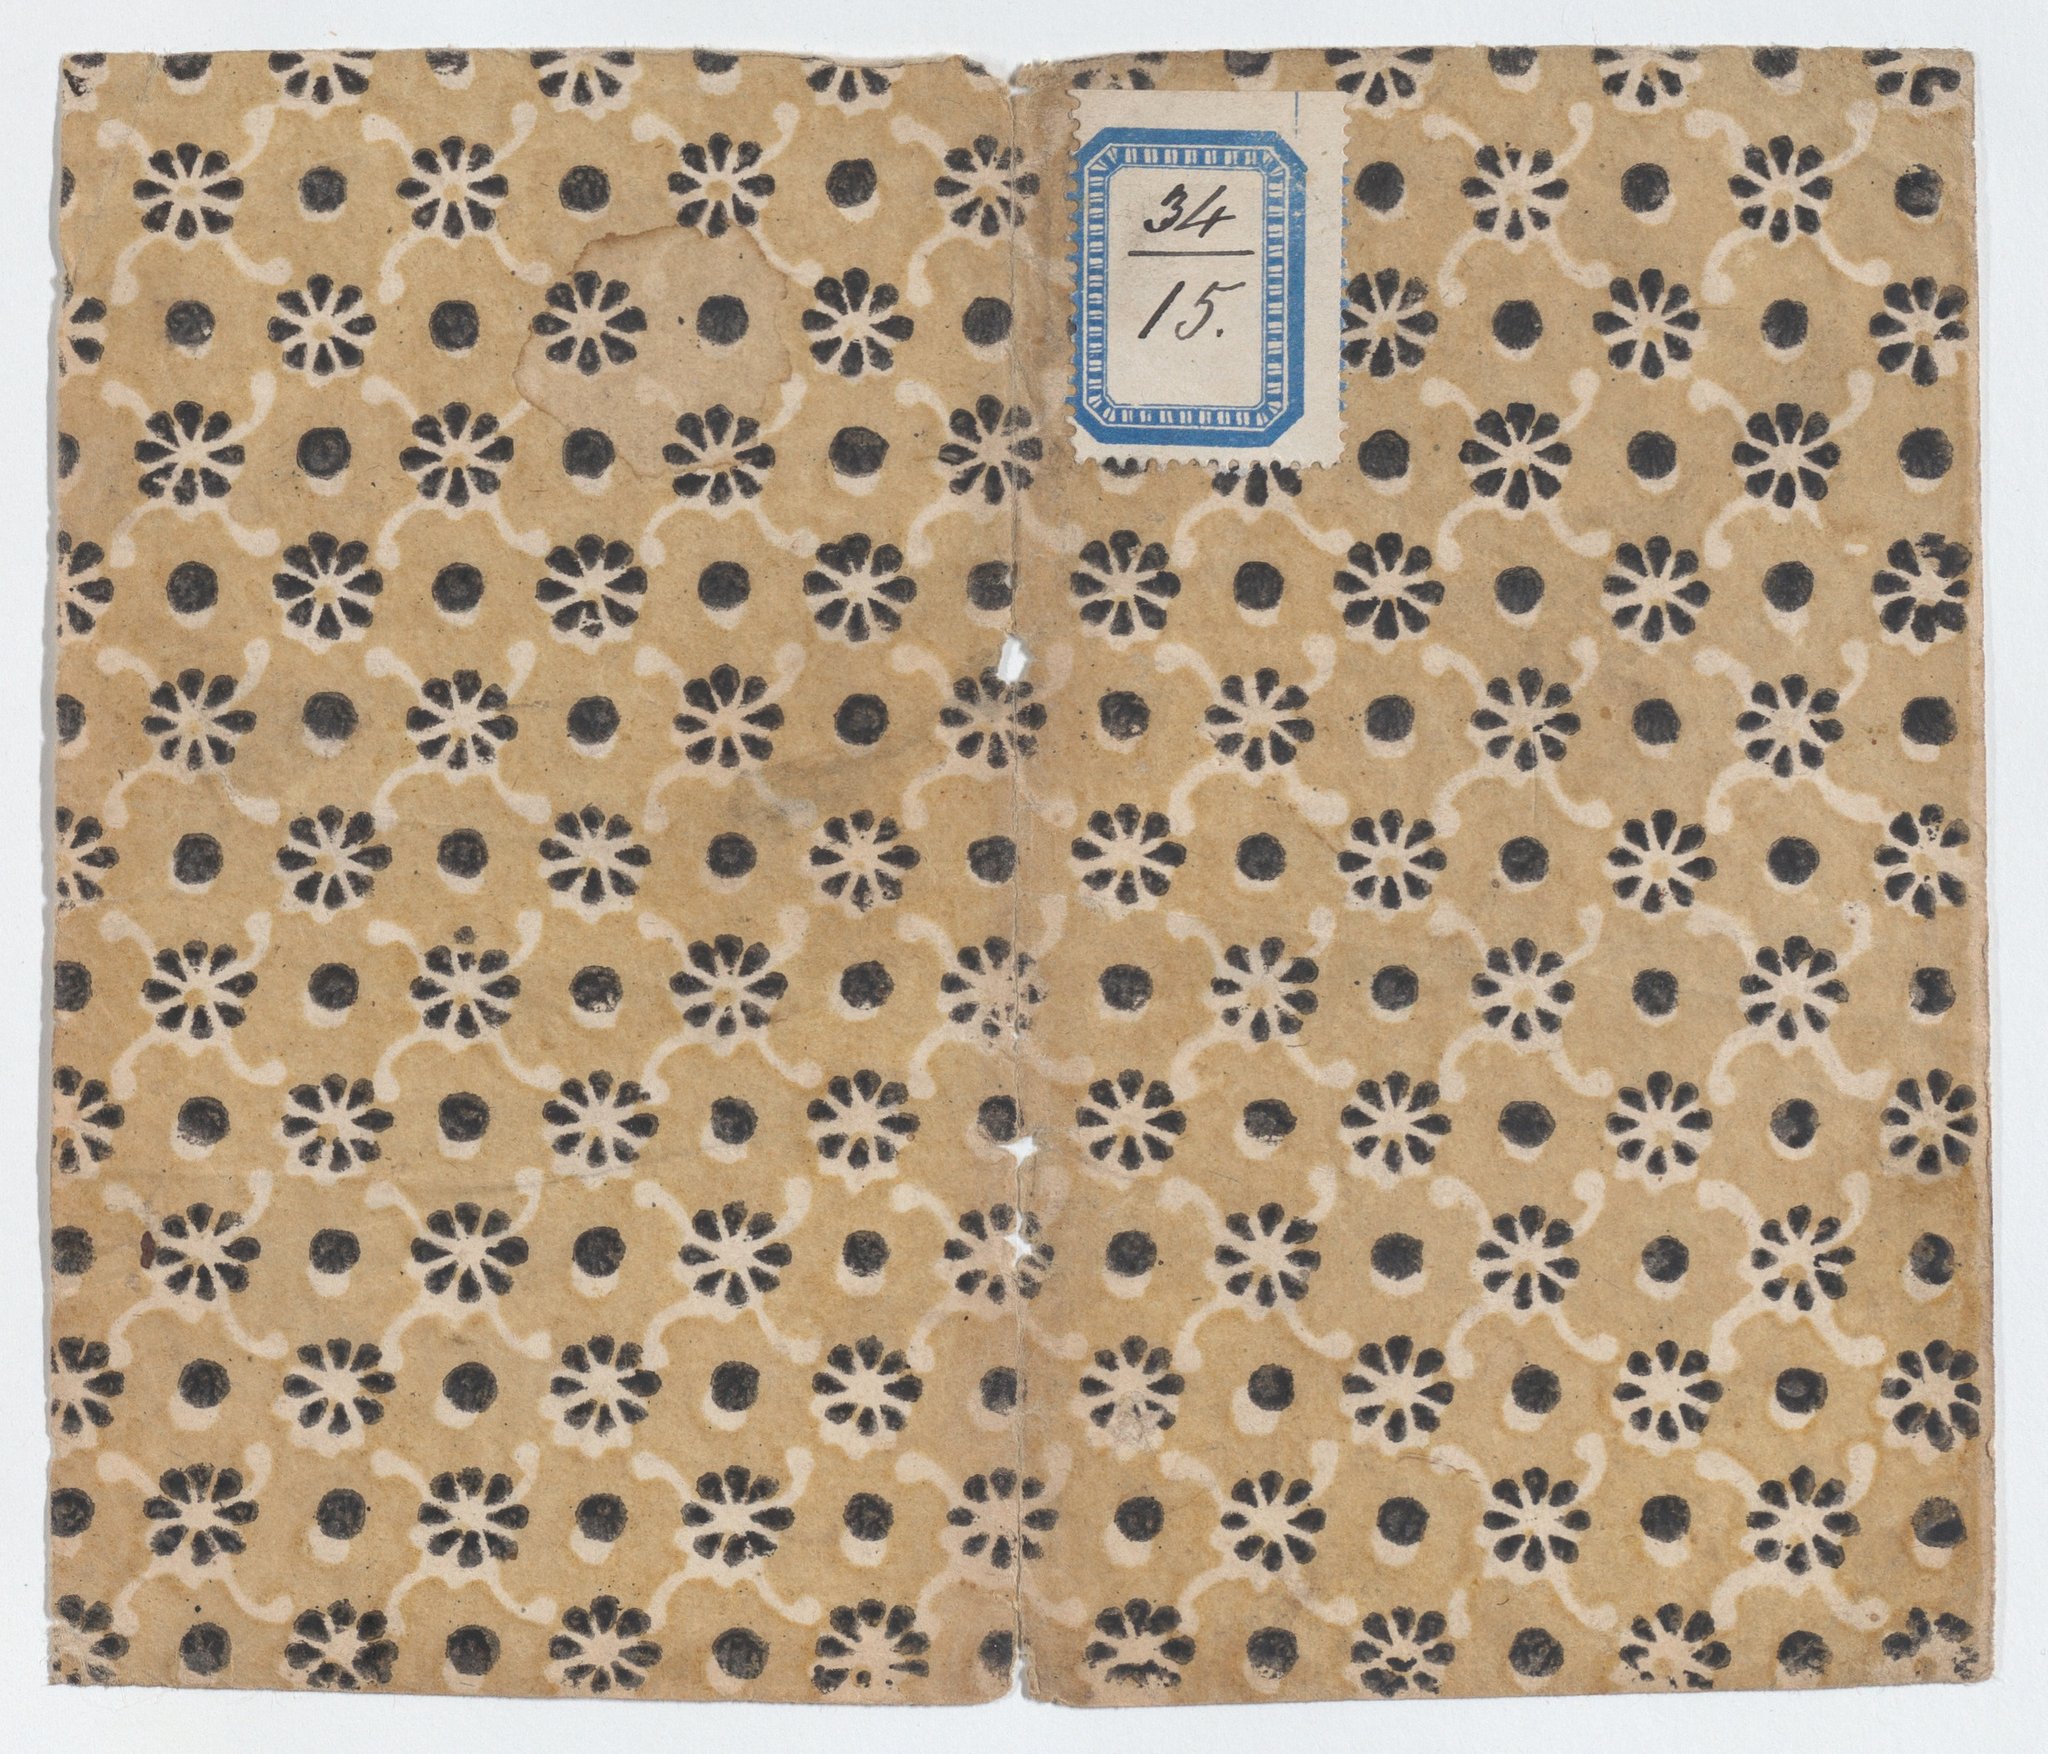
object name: print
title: Book cover with overall floral and dot pattern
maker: Anonymous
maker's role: artist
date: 1801-1900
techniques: relief print